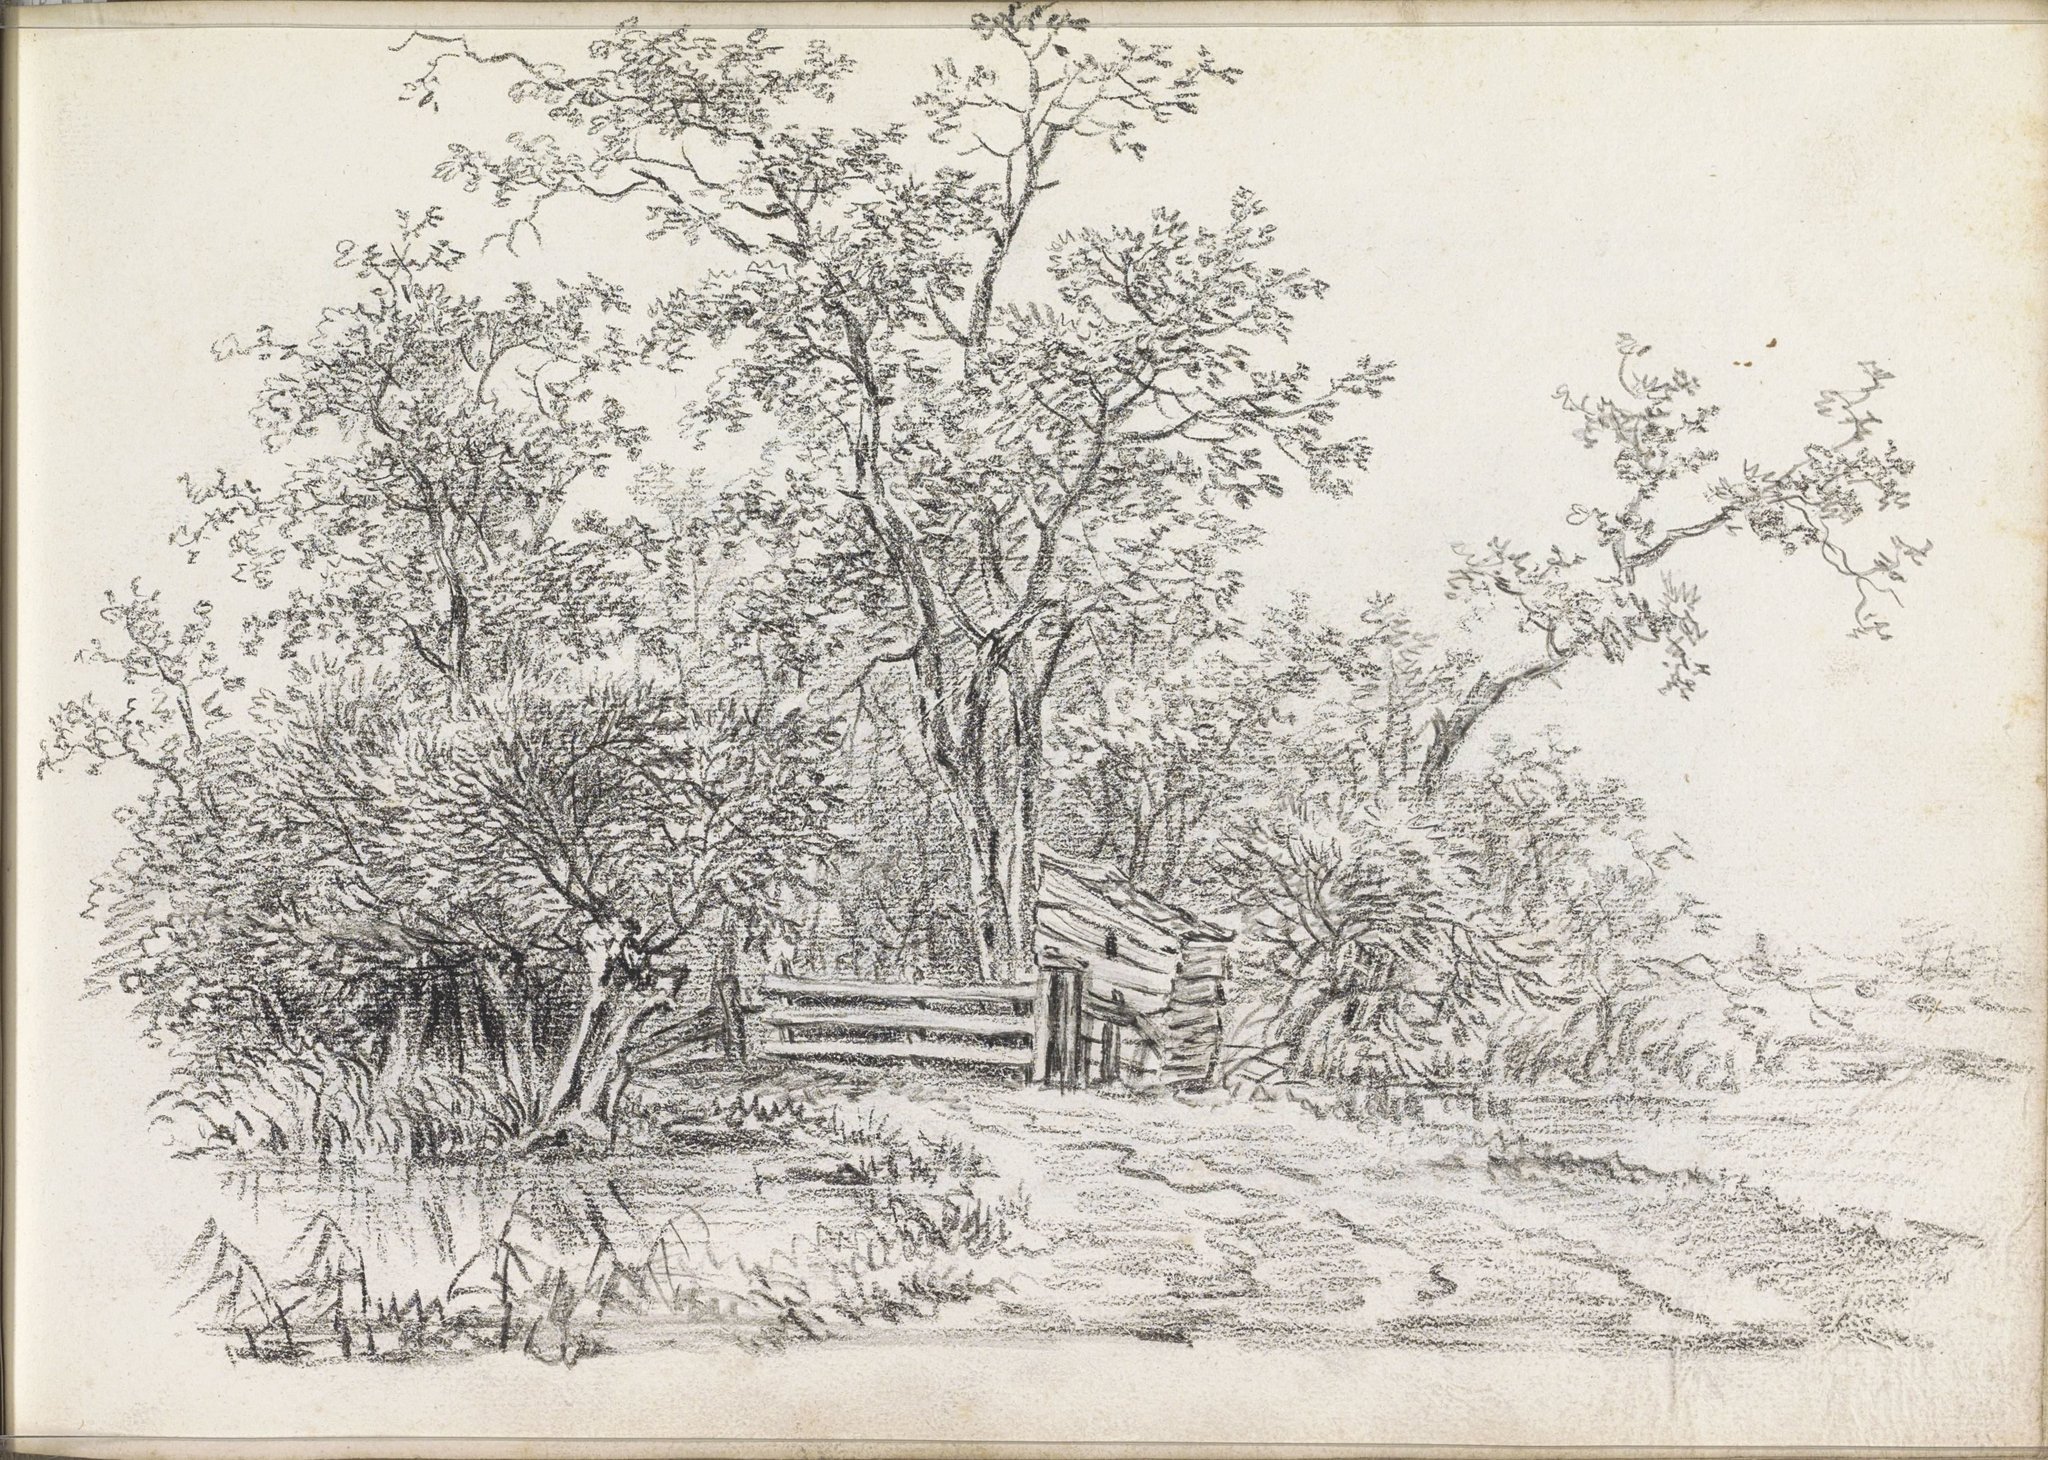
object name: sketchbook leaf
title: Landschap met een hut en hek bij een waterkant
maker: andreas schelfhout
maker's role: draughtsman, painter, print maker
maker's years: 1787-1870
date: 1811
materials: chalk, paper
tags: fence, wall, paling, landscapes with waters, waterscapes, seascapes (in the temperate zone)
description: Blad 42 recto uit een schetsboek met 75 bladen.